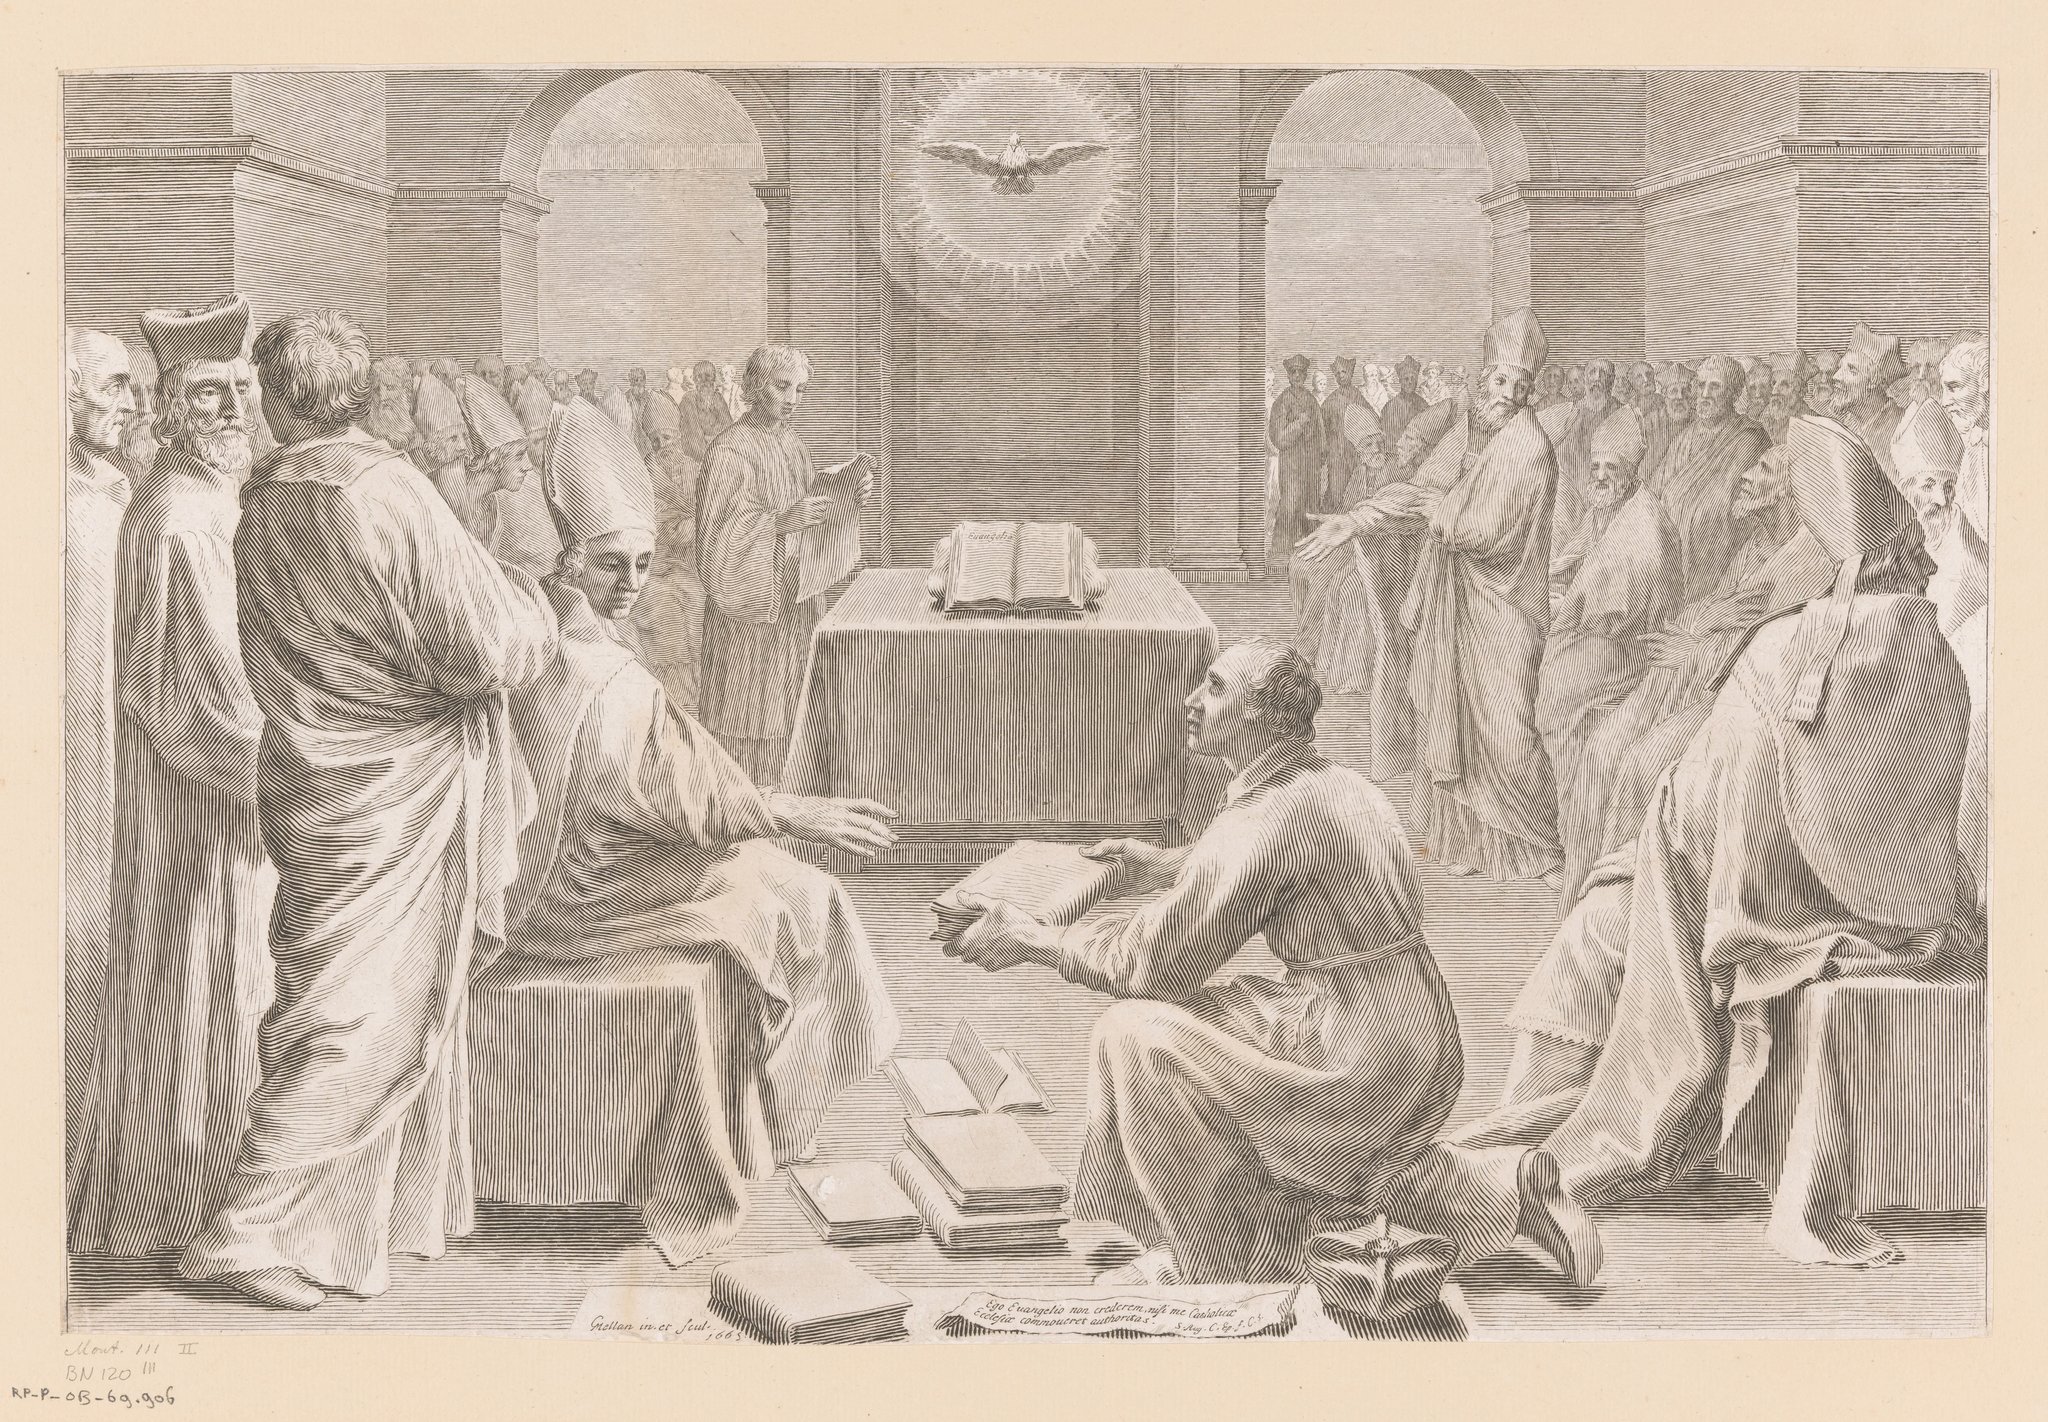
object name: print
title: Concilie met de Heilige Geest boven het Evangelie, omringd door geestelijken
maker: claude mellan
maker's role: draughtsman, print maker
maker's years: 1598-1688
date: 1665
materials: paper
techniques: engraving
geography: france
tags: council, synod ~ roman catholic church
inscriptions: collector's mark: Lugt 240